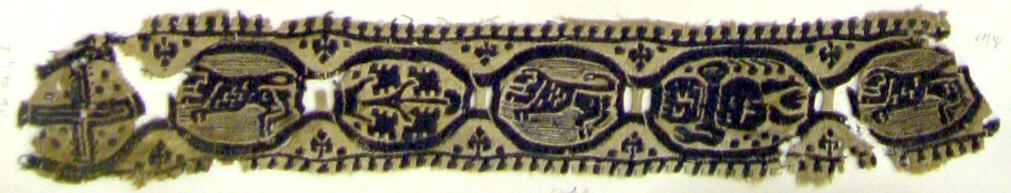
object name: textile fragment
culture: coptic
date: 300-600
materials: linen, wool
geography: egypt